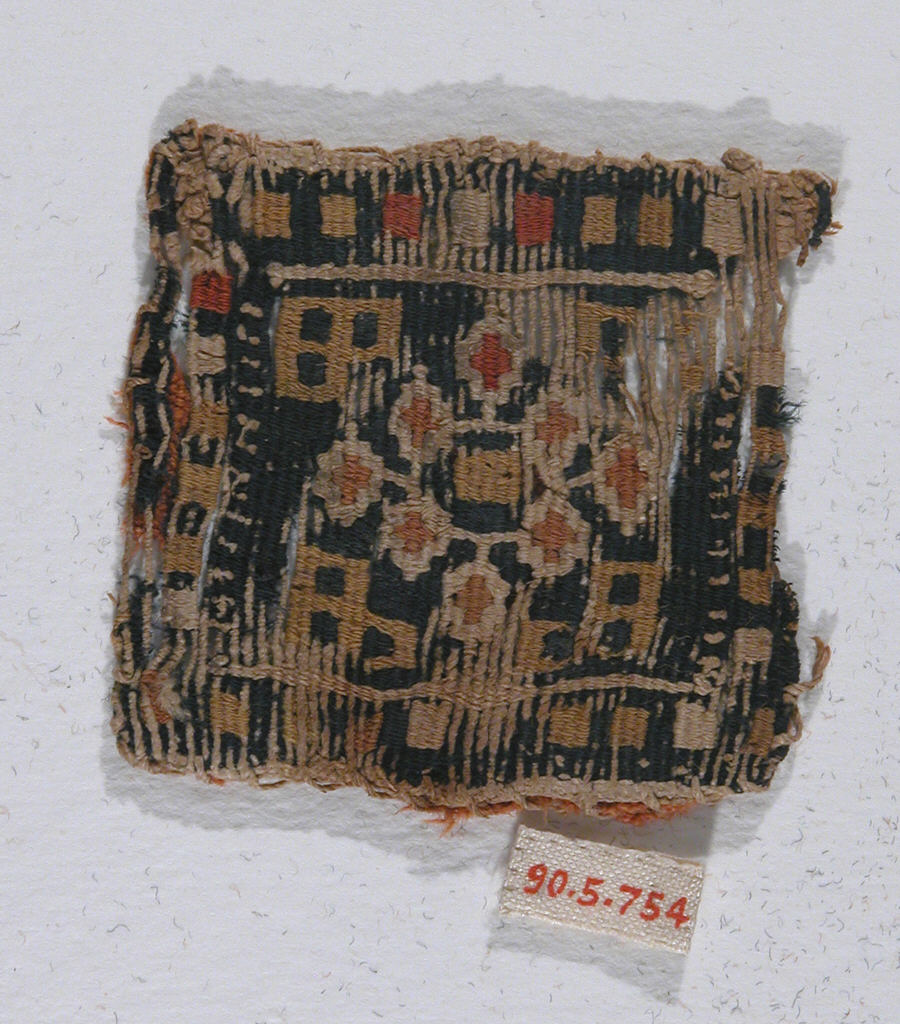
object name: textile fragment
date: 401-600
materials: linen, wool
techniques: weave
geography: egypt